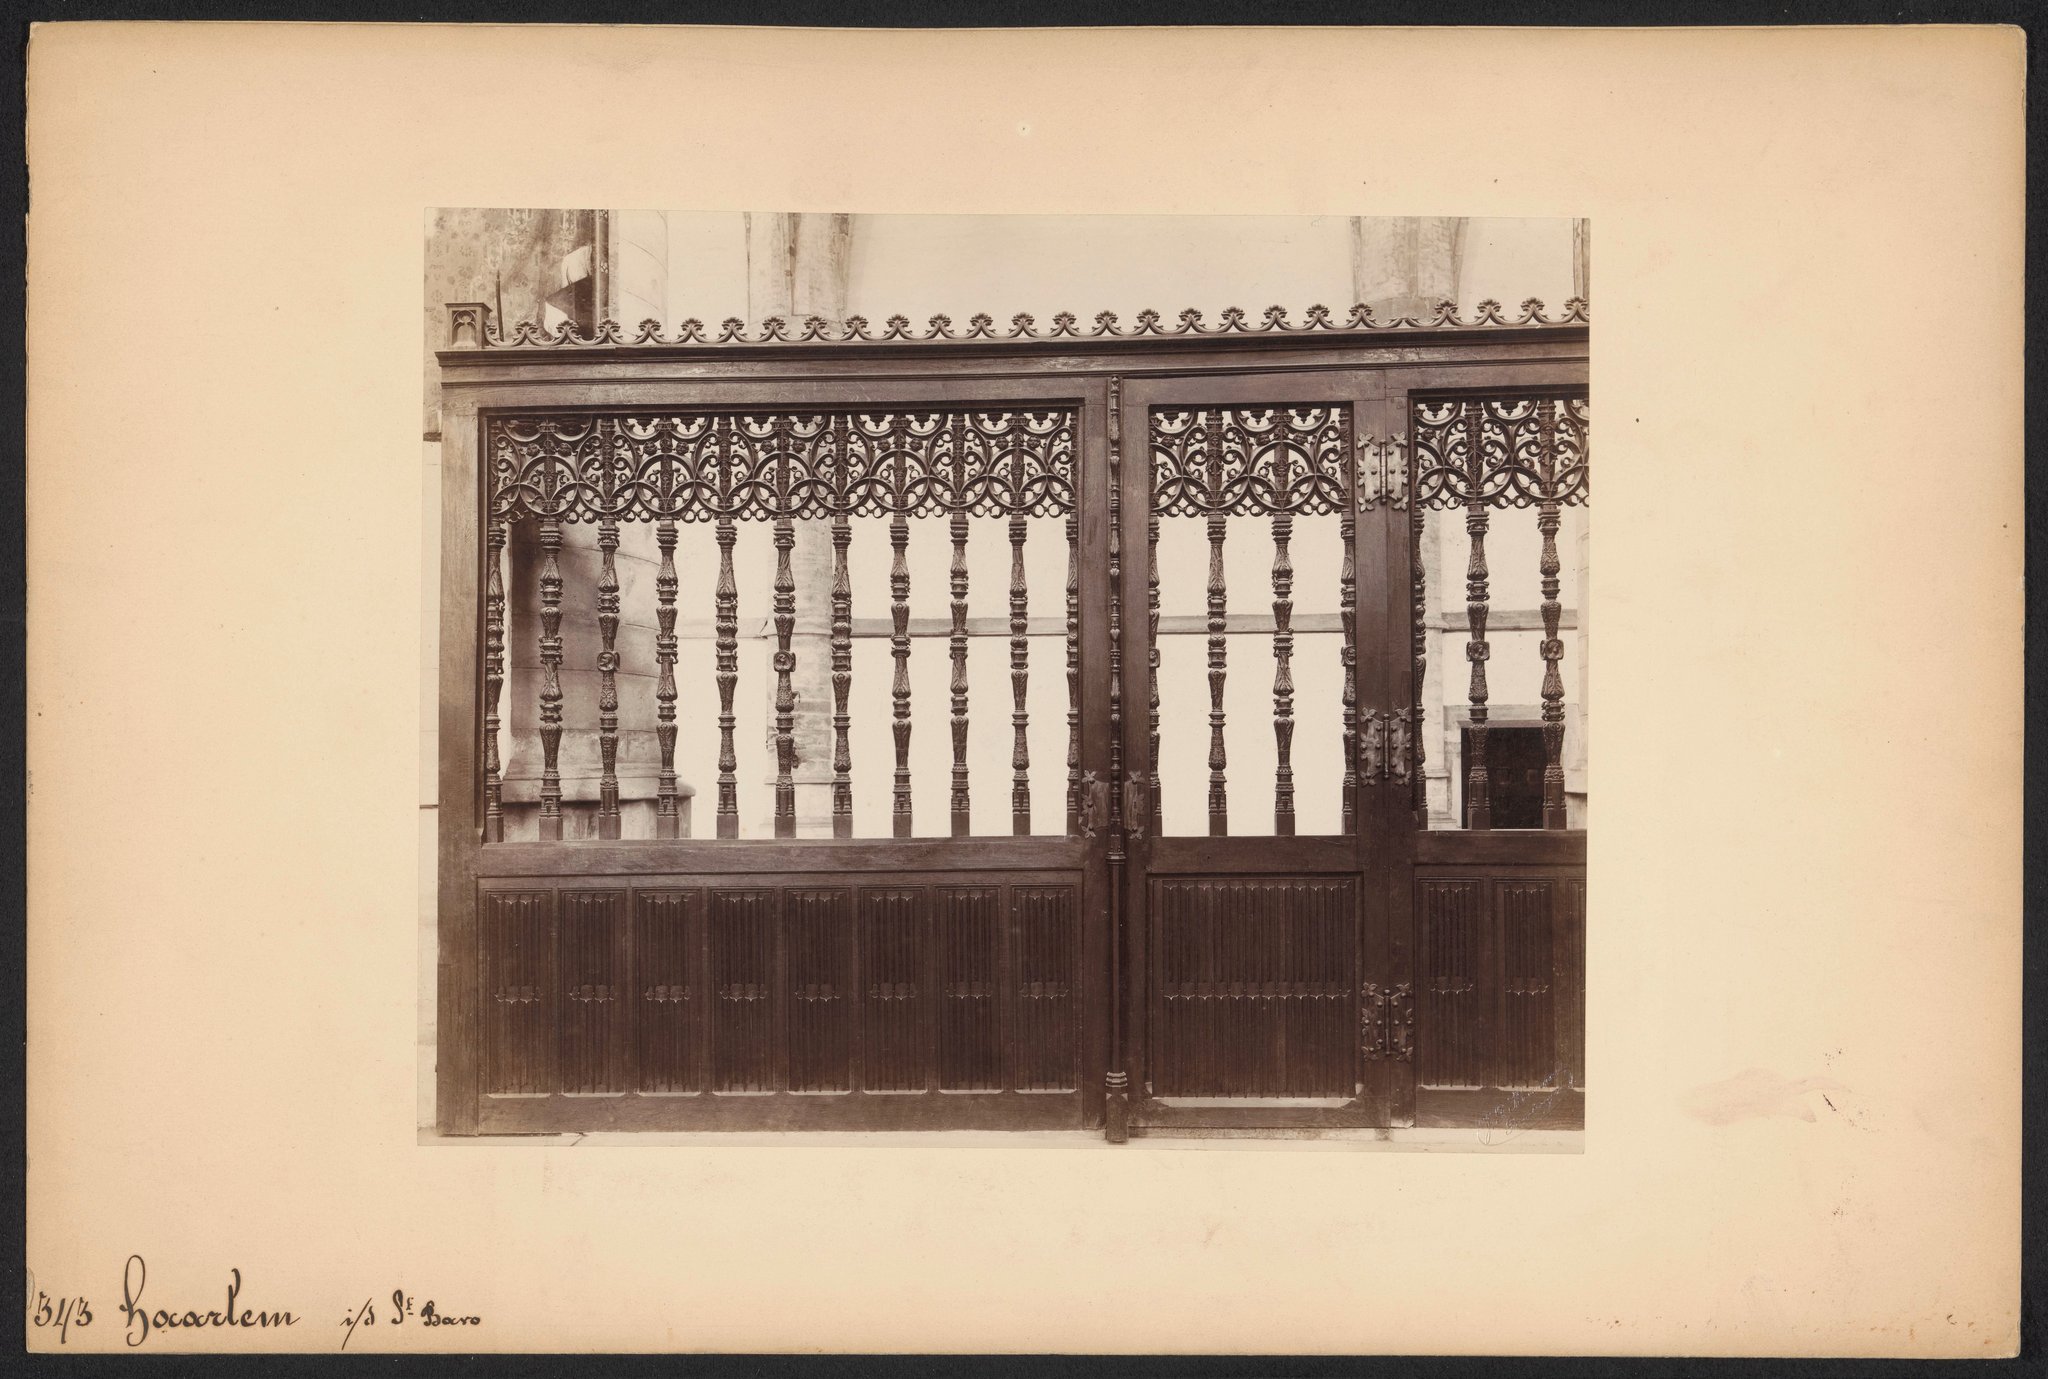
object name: photograph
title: Deel van het koorhek in de Sint-Bavokerk te Haarlem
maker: johannes gerardus kramer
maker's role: fotograaf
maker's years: 1845-1903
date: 1875-1900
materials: cardboard, photographic support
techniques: albumen print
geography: haarlem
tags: rood-screen, choir-screen; iconostasis, parts of church interior: choir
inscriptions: collector's mark: Lugt 3937, inscription: ‘X ki fl 1’, name: ‘J.G. Kramer Groningen’, inscription: ‘haarlem i/d St Bavo’, number: ‘343’